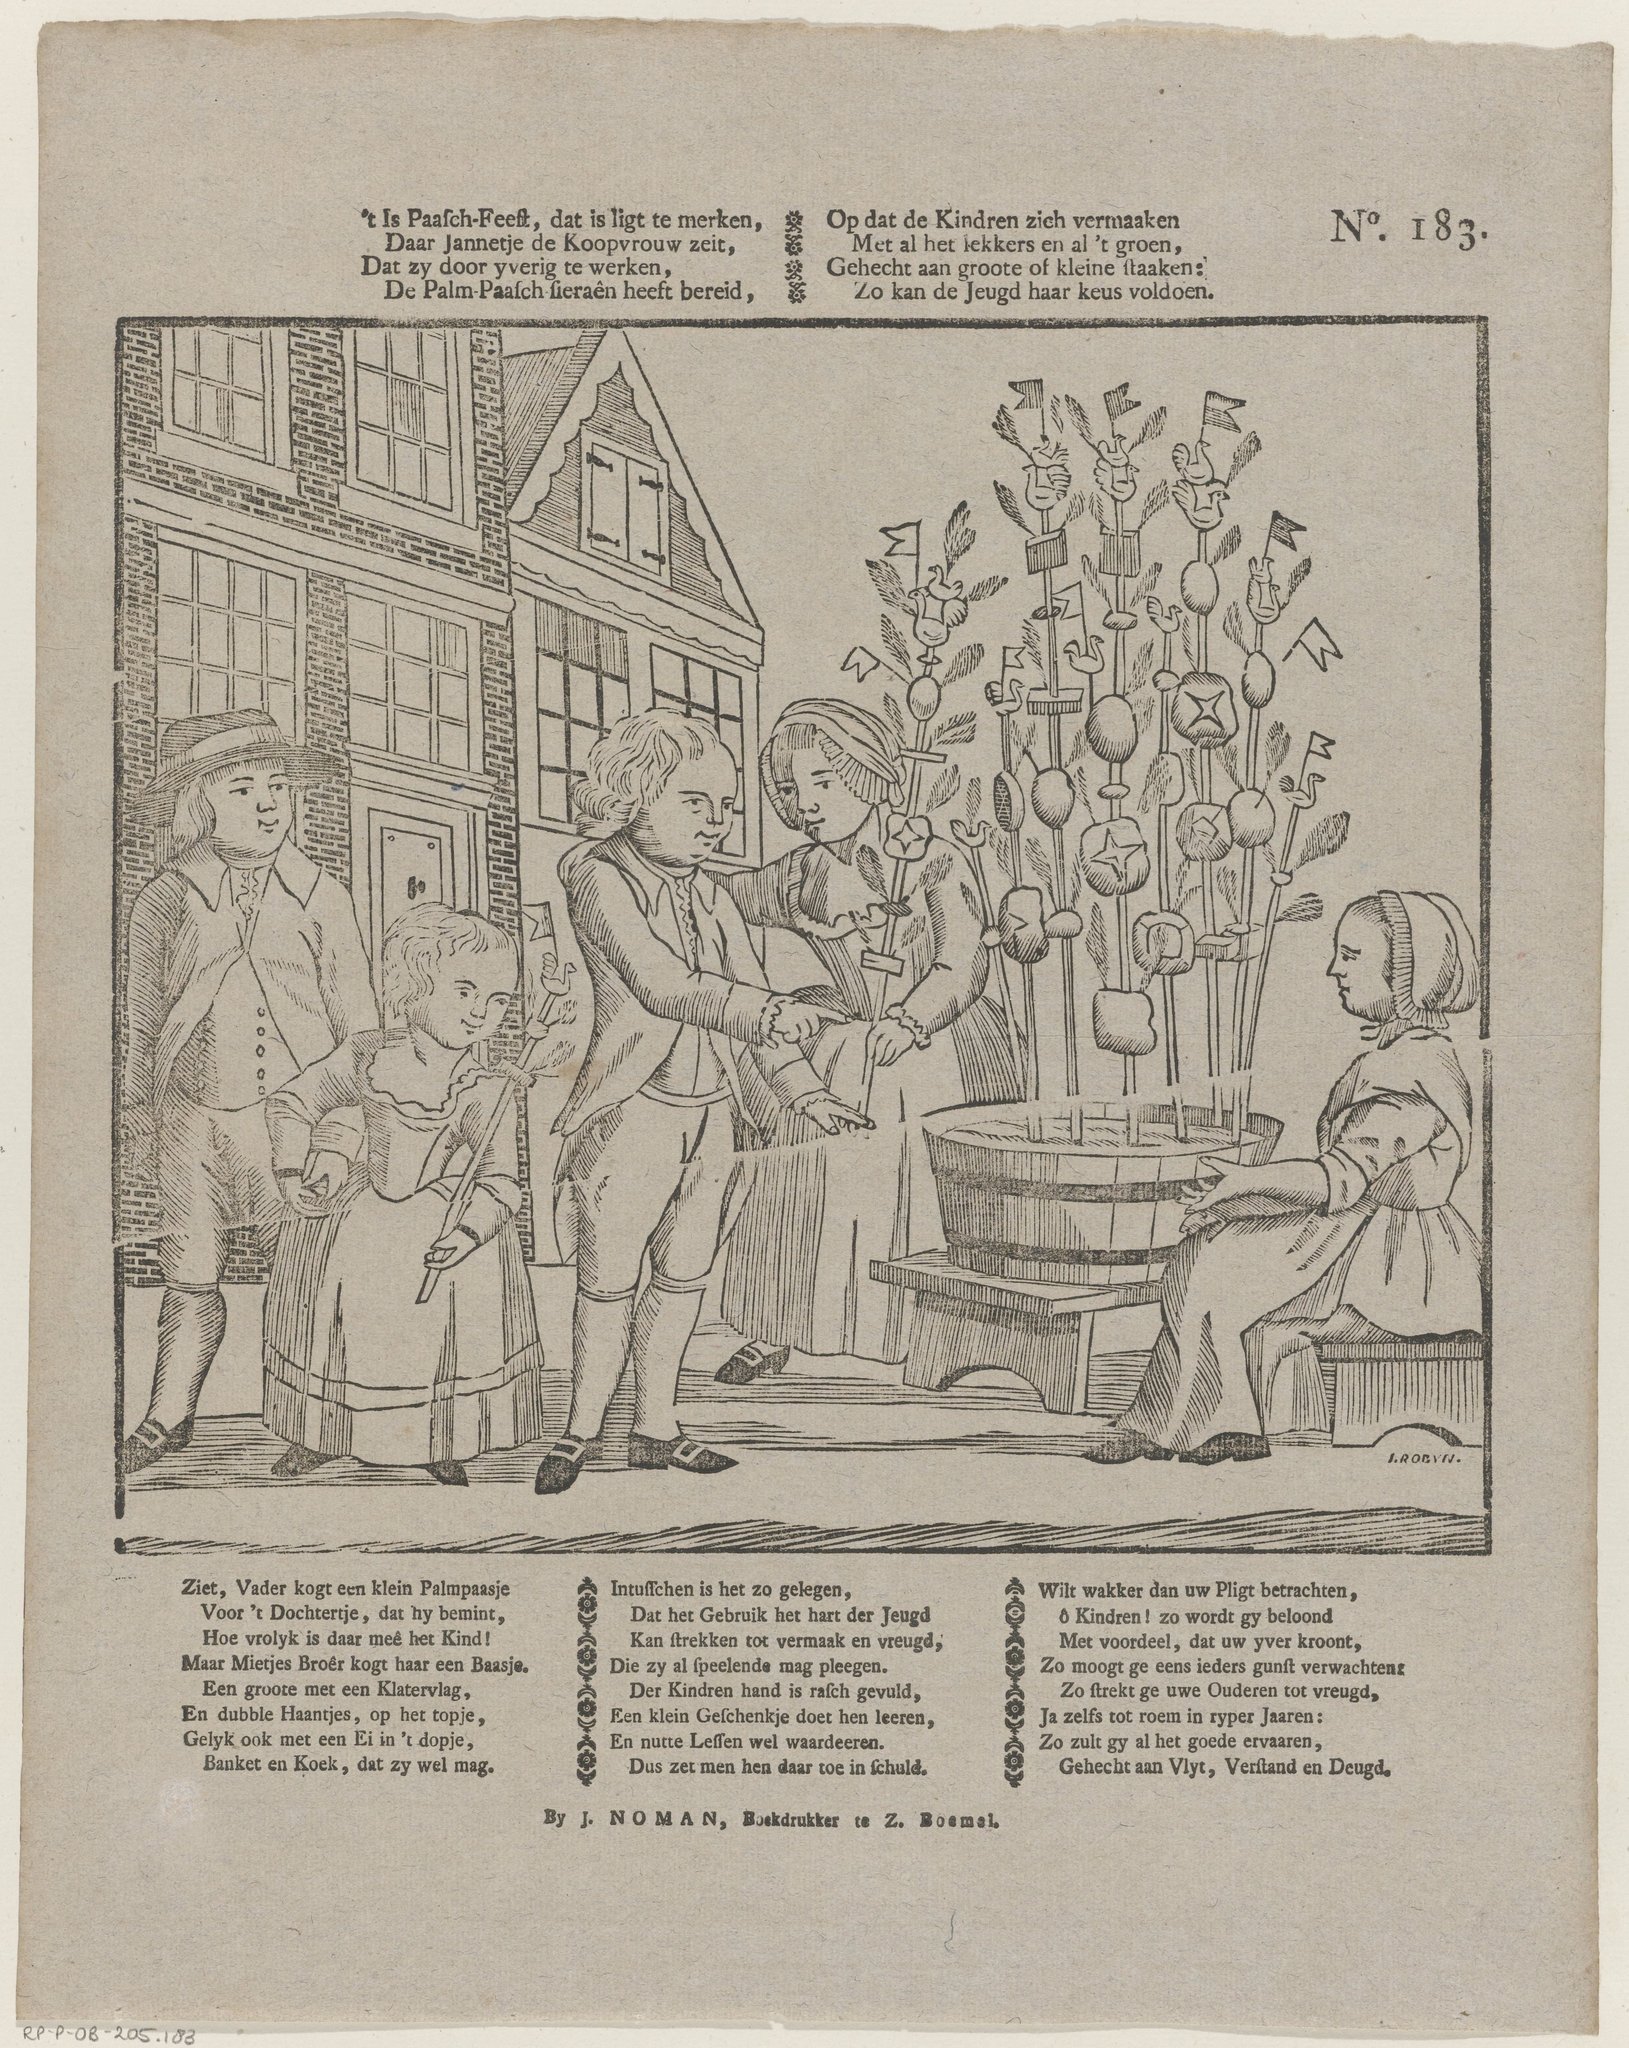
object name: popular print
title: 't is Paasch-feest, dat is ligt te merken, / Daar Jannetje de koopvrouw zeit [(...)]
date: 1806-1830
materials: paper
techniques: letterpress printing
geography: zaltbommel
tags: palm sunday, street-trader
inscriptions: collector's mark: Lugt 2760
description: Blad met een grote voorstelling van een straatverkoopster die palmpaasstokken verkoopt. In de ondermarge een vers in drie kolommen. Genummerd rechtsboven: No. 183.